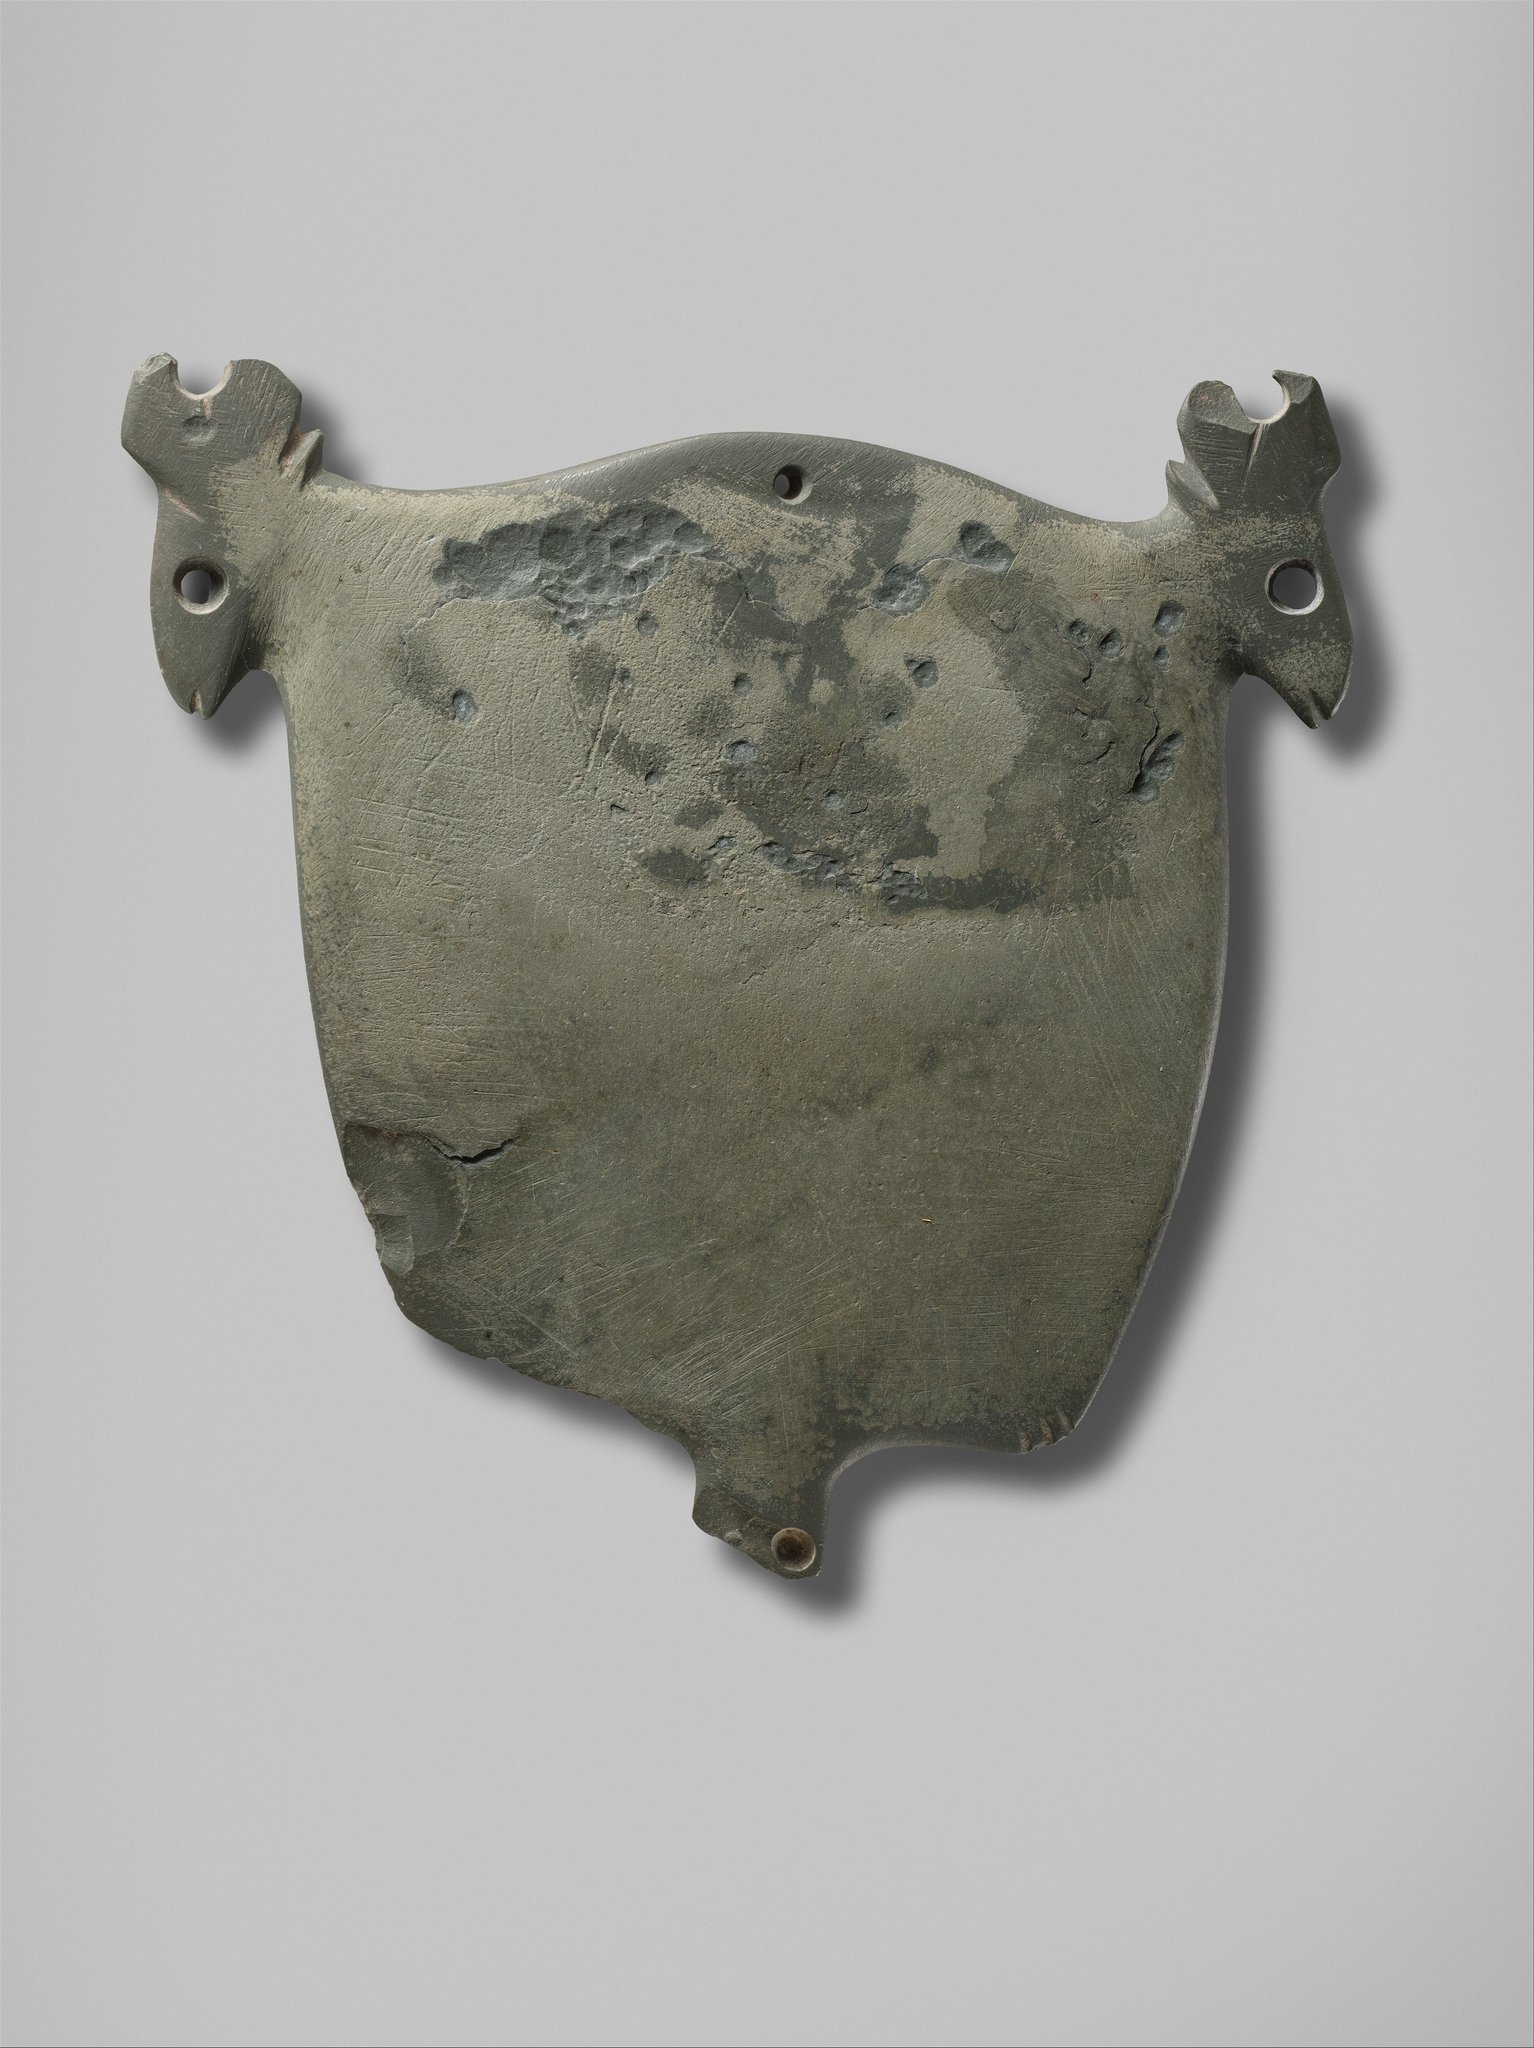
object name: palette, antelope head, turtle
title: Palette with antelope heads and a turtle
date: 3650-3500 BCE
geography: egypt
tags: animals